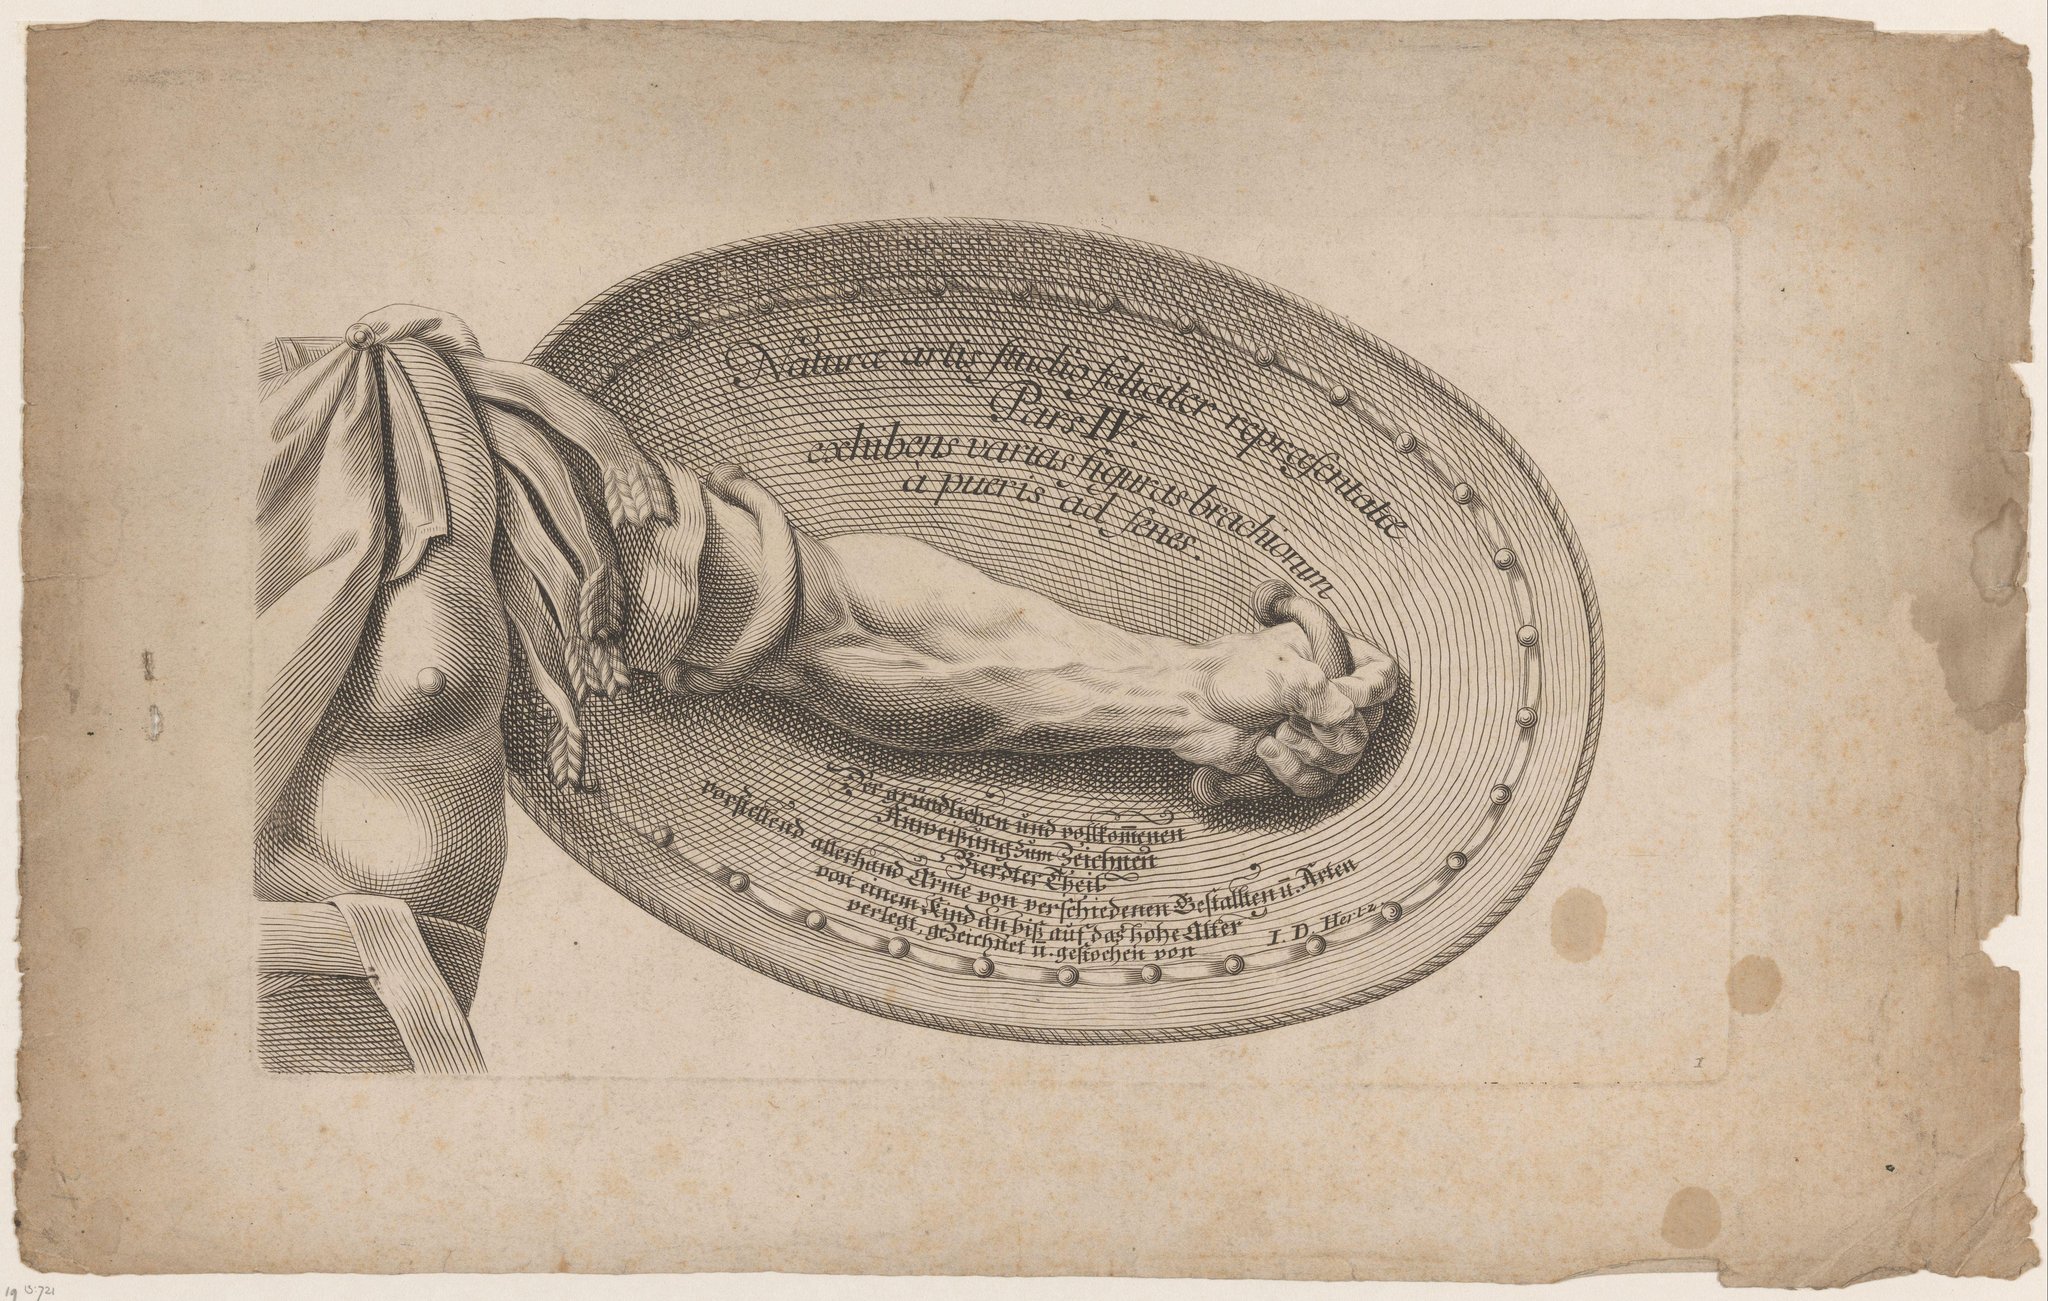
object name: print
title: Titelprent voor de serie Anweisung zum zeichnen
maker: johann daniel herz (i)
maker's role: print maker, publisher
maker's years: 1693-1754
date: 1723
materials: paper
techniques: engraving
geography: augsburg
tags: drawing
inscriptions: collector's mark: Lugt 2233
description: Titelprent voor: Herz, Johann Daniel. Naturae artis studio feliciter repraesentatae (...). Augsburg: Johan Daniel Herz, [1723].